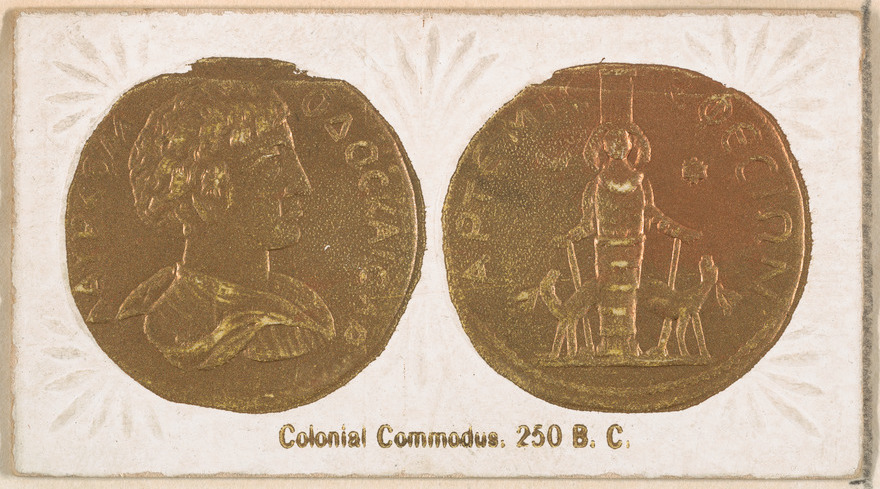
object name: print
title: Colonial Commodus, 250 B.C., from the Ancient Coins series (N180) issued by Wm. S. Kimball & Co.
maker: william s. kimball & company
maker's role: publisher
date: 1888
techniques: color lithograph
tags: men,coins